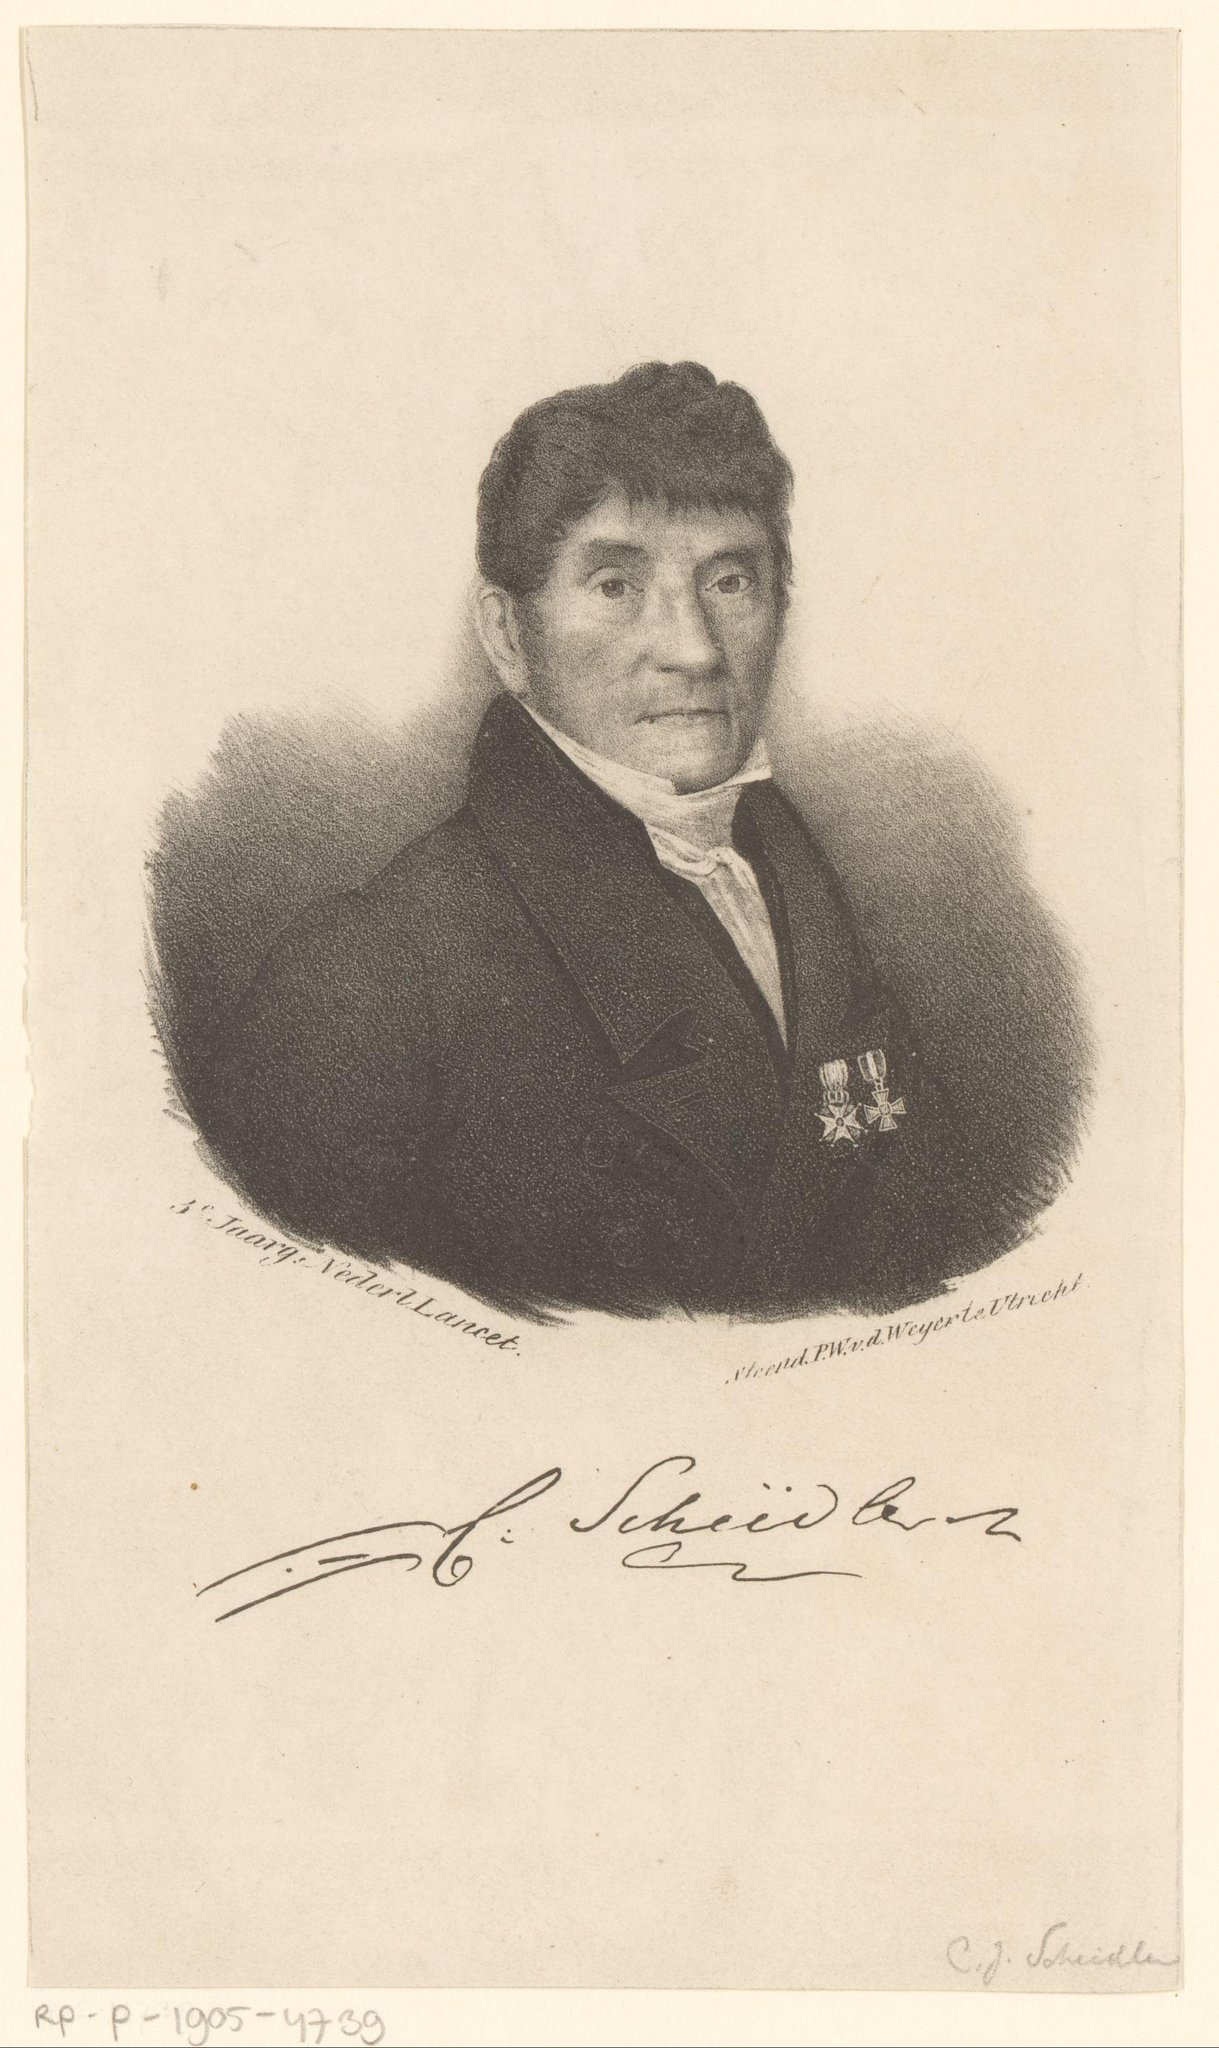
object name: print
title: Portret van C.J. Scheidler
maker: pieter wilhelmus van de weijer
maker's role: print maker, printer, publisher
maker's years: 1816-1880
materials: paper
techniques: lithograph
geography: utrecht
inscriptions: collector's mark: Lugt 2228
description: Op de prent staat vermeld dat deze werd uitgegeven in de derde jaargang van Het Nederlandsch Lancet.